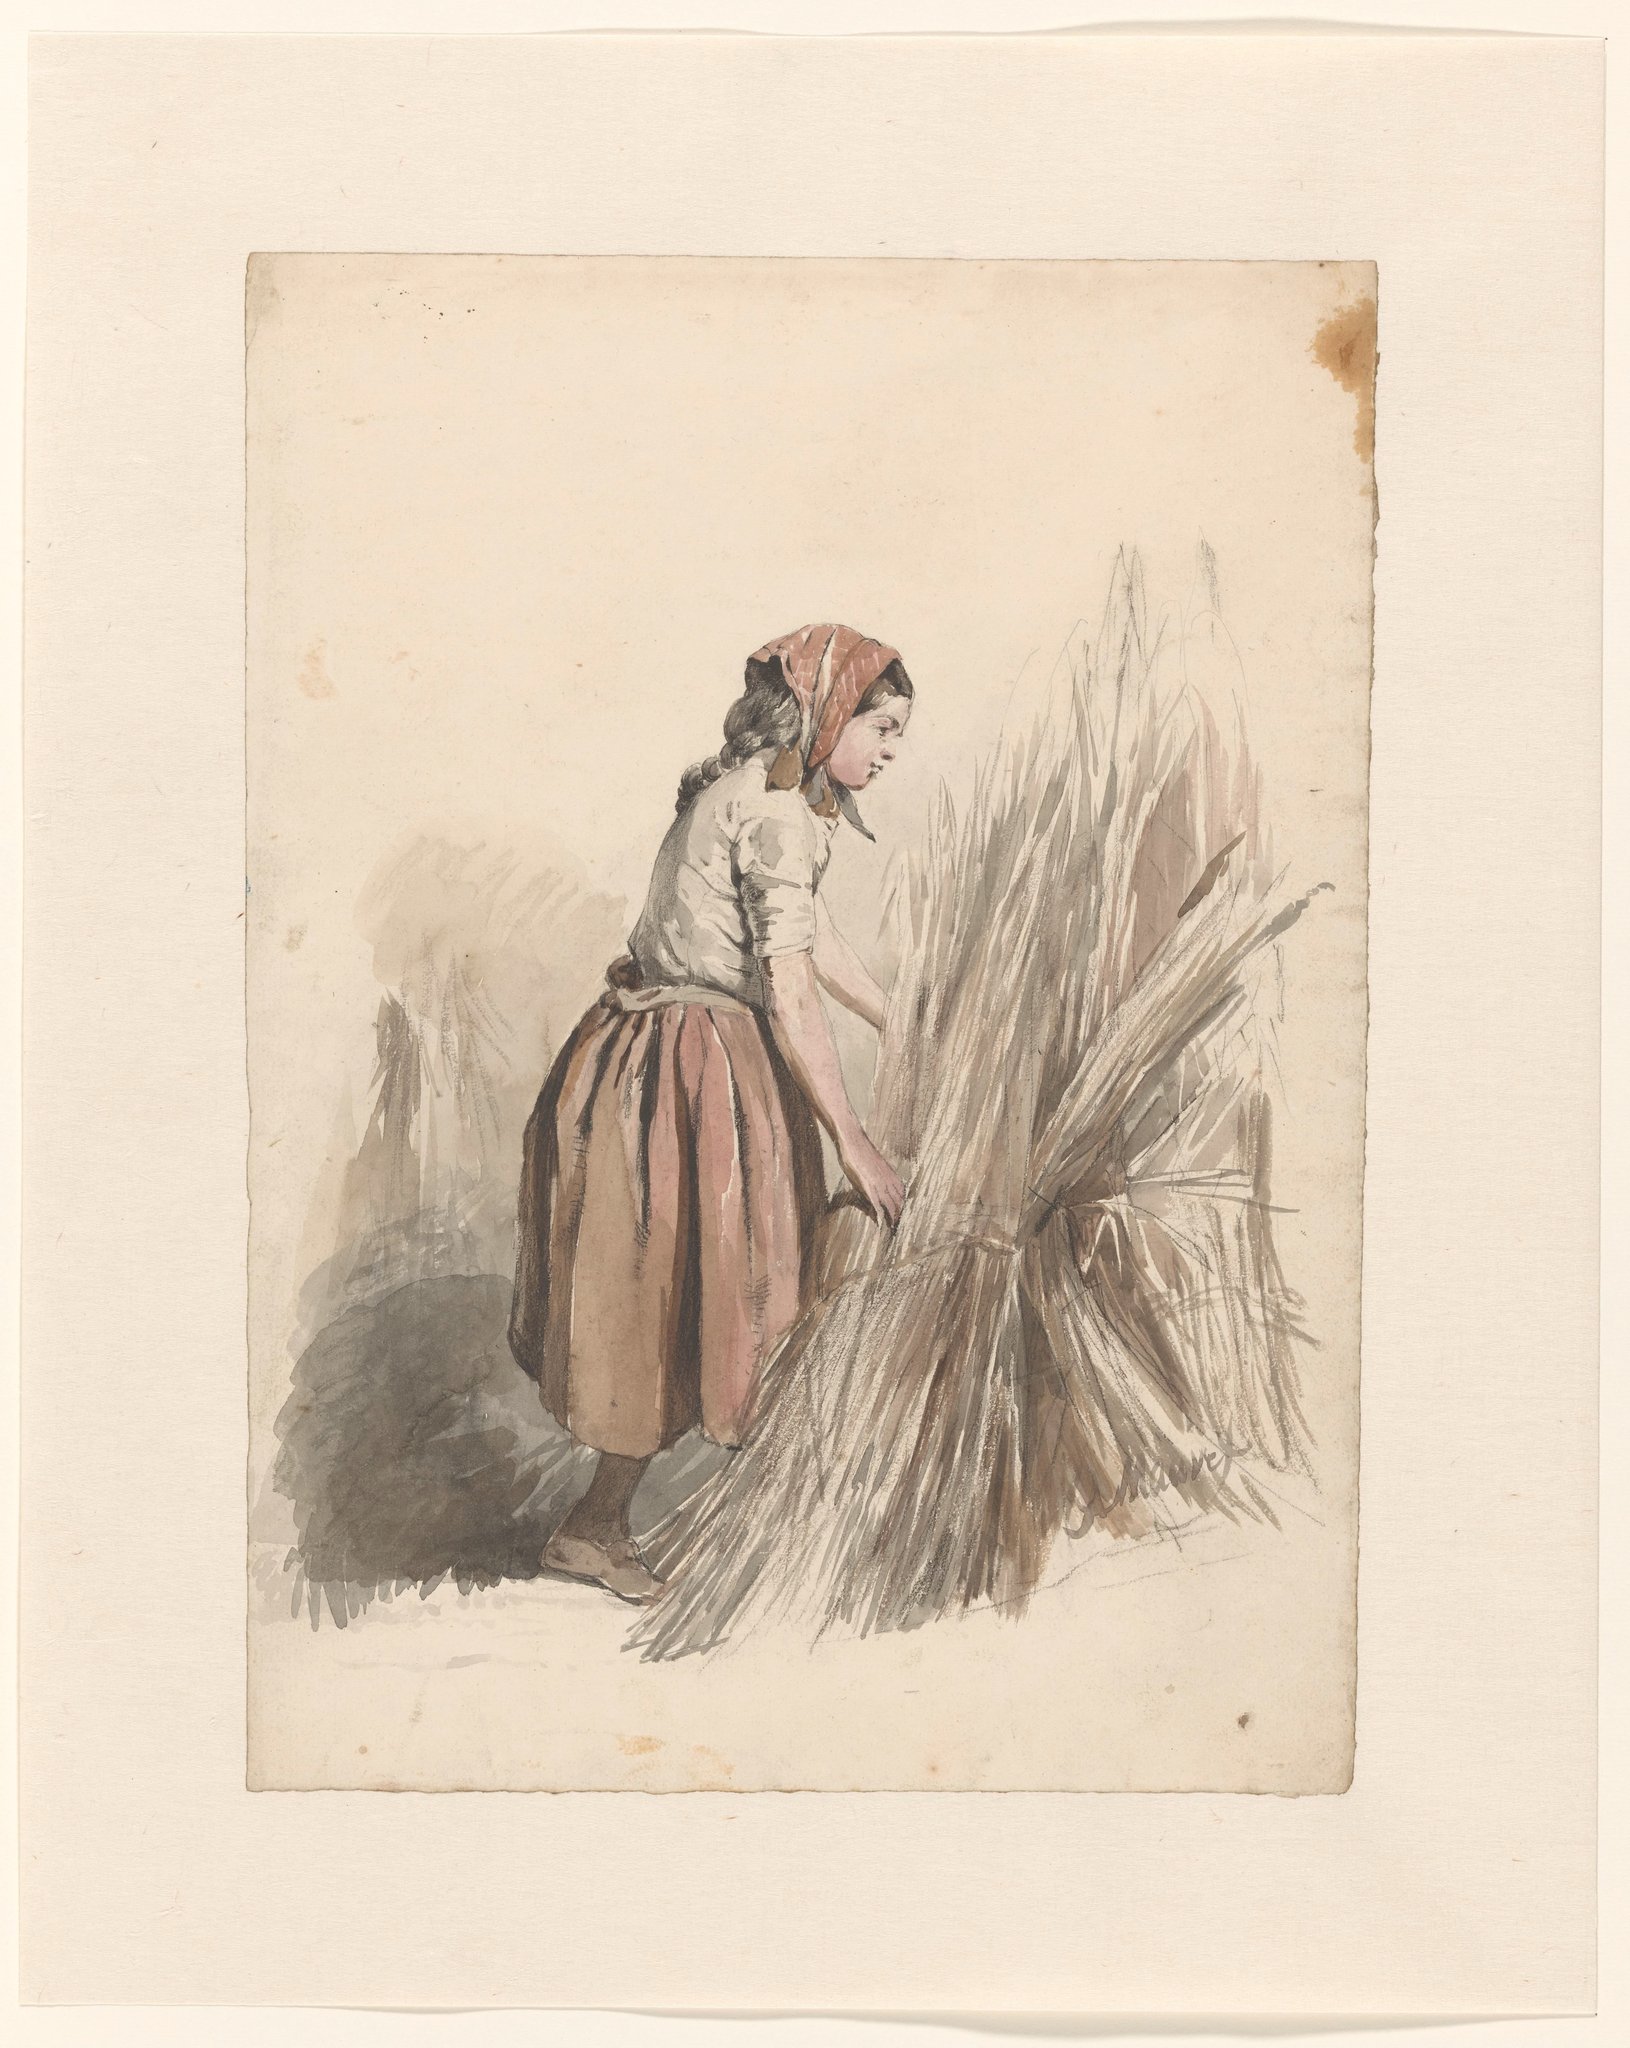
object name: drawing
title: Meisje met hoofddoek, werkend op het land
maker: anton mauve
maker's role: draughtsman, painter, print maker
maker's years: 1838-1888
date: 1848-1888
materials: chalk, paper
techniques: brush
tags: harvest